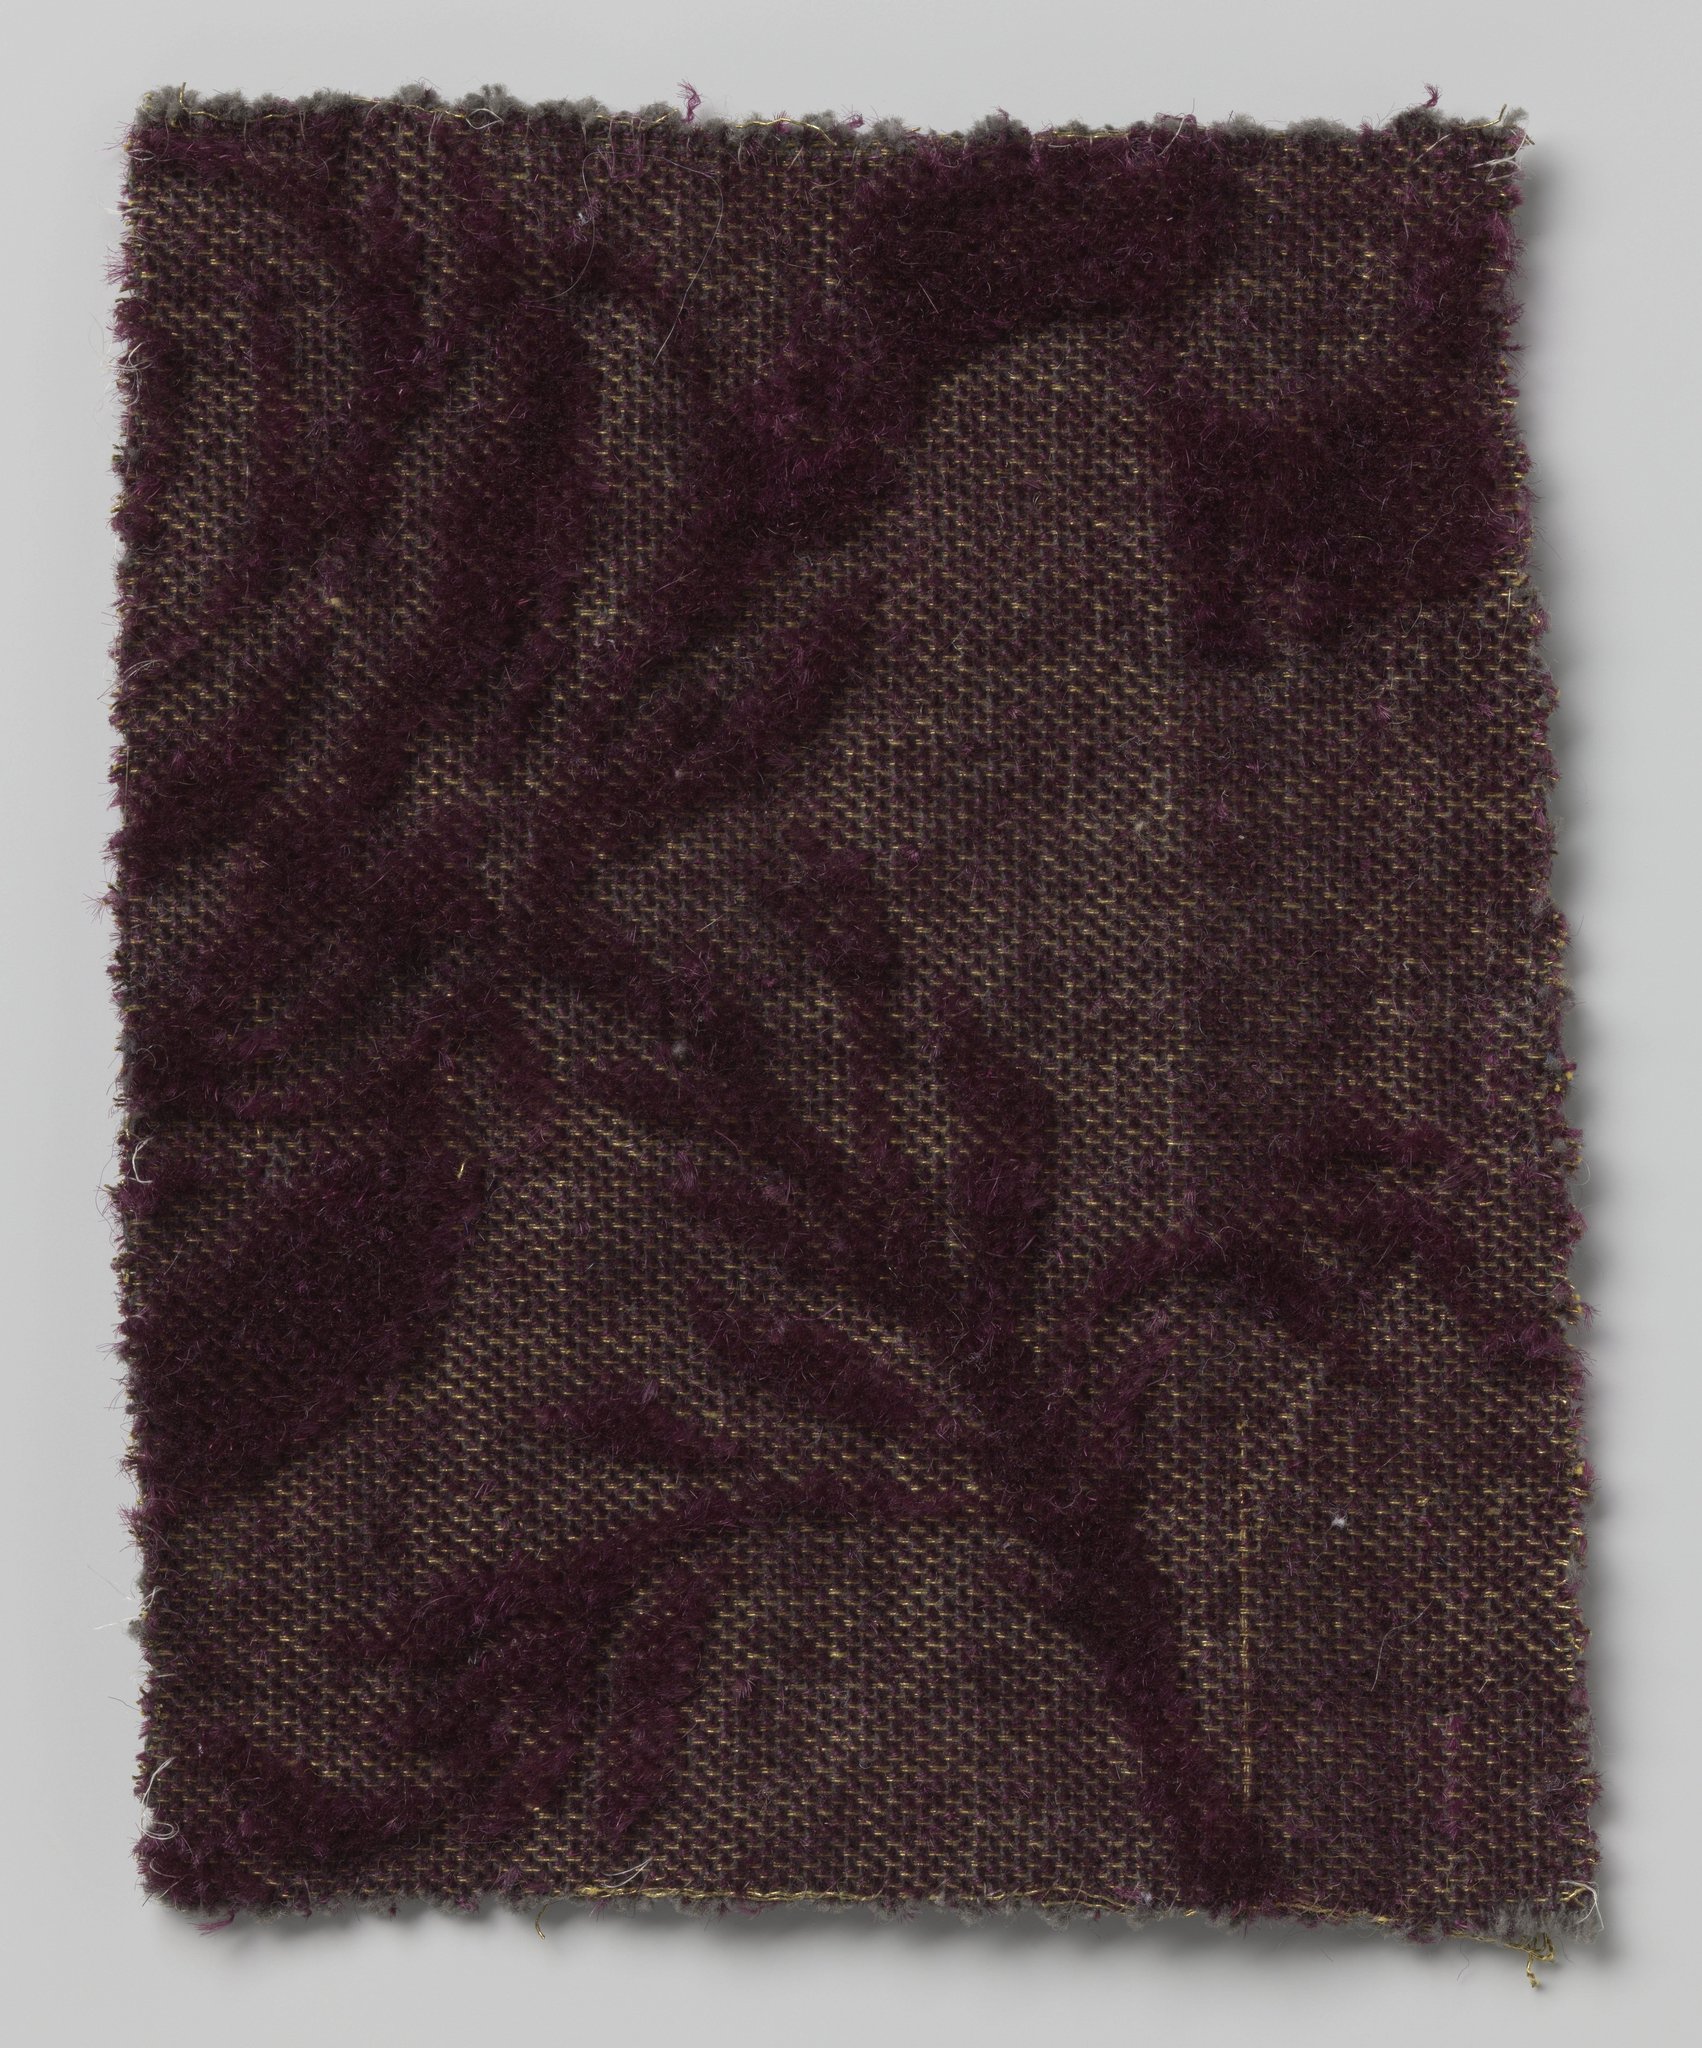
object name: woven material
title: Fragment ingeschoren trijp met een roos, purper op goud.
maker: Anonymous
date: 1800-1950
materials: cotton, textile, hair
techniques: relief velvet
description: Fragment ingeschoren trijp met een roos aan stengel, purper op goud.